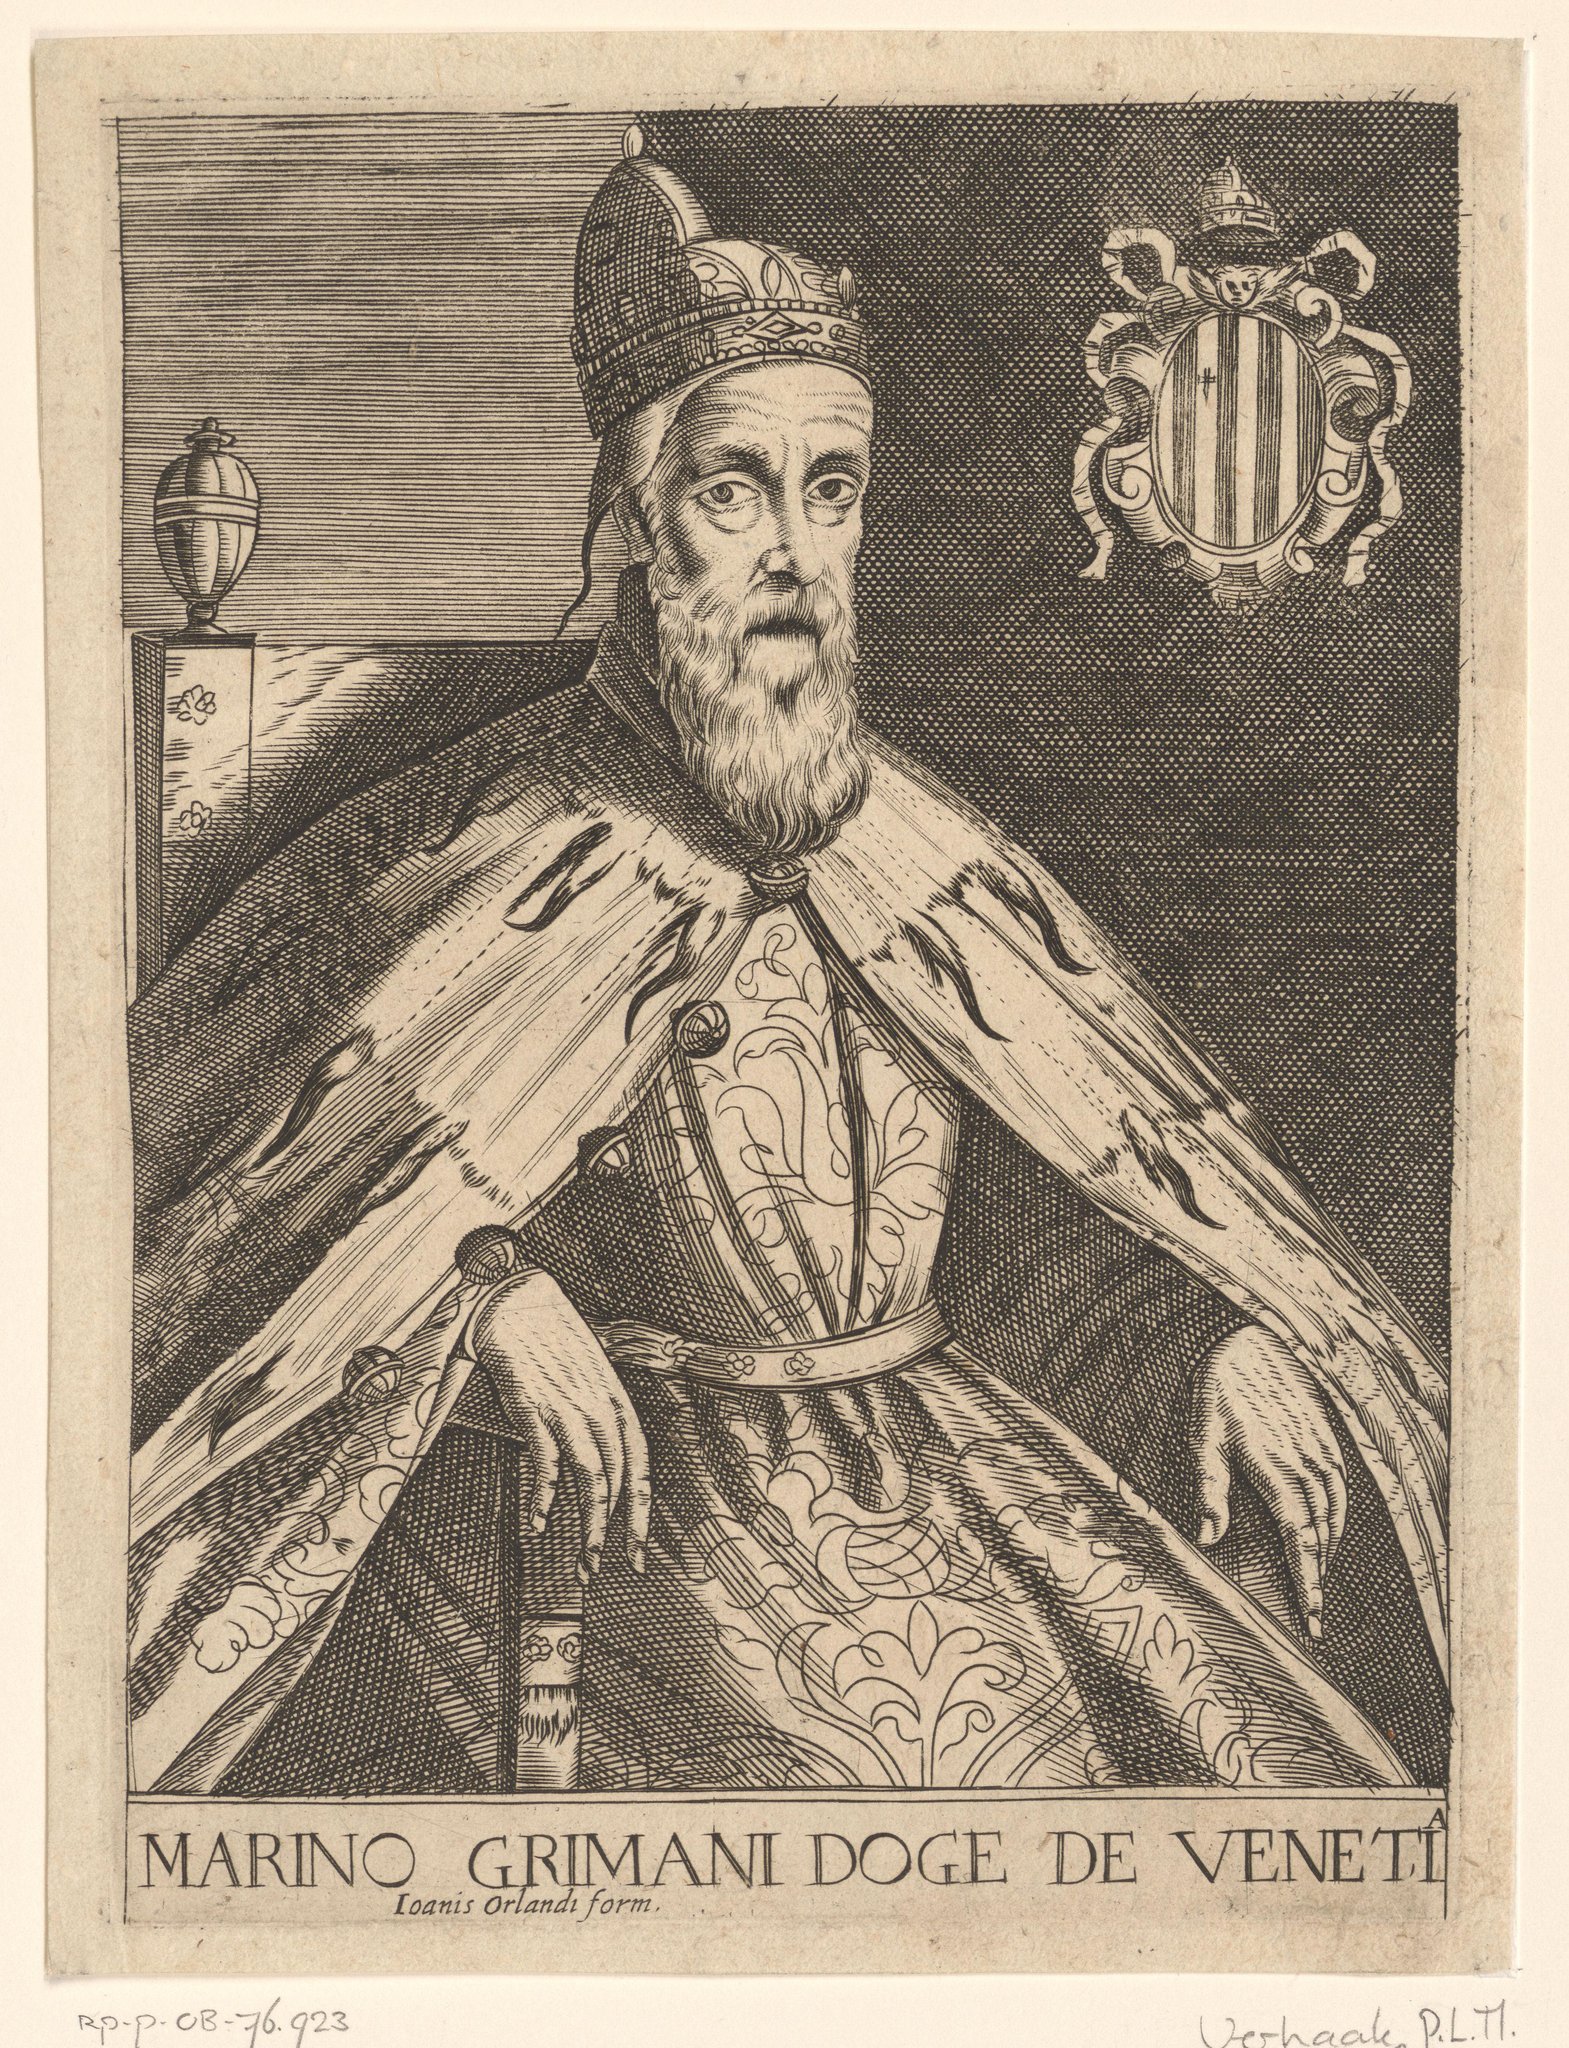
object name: print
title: Portret van Marino Grimani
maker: giovanni orlandi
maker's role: print maker, printer, publisher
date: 1590-1640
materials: paper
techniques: engraving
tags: venice, historical persons, politician, e.g. party leader